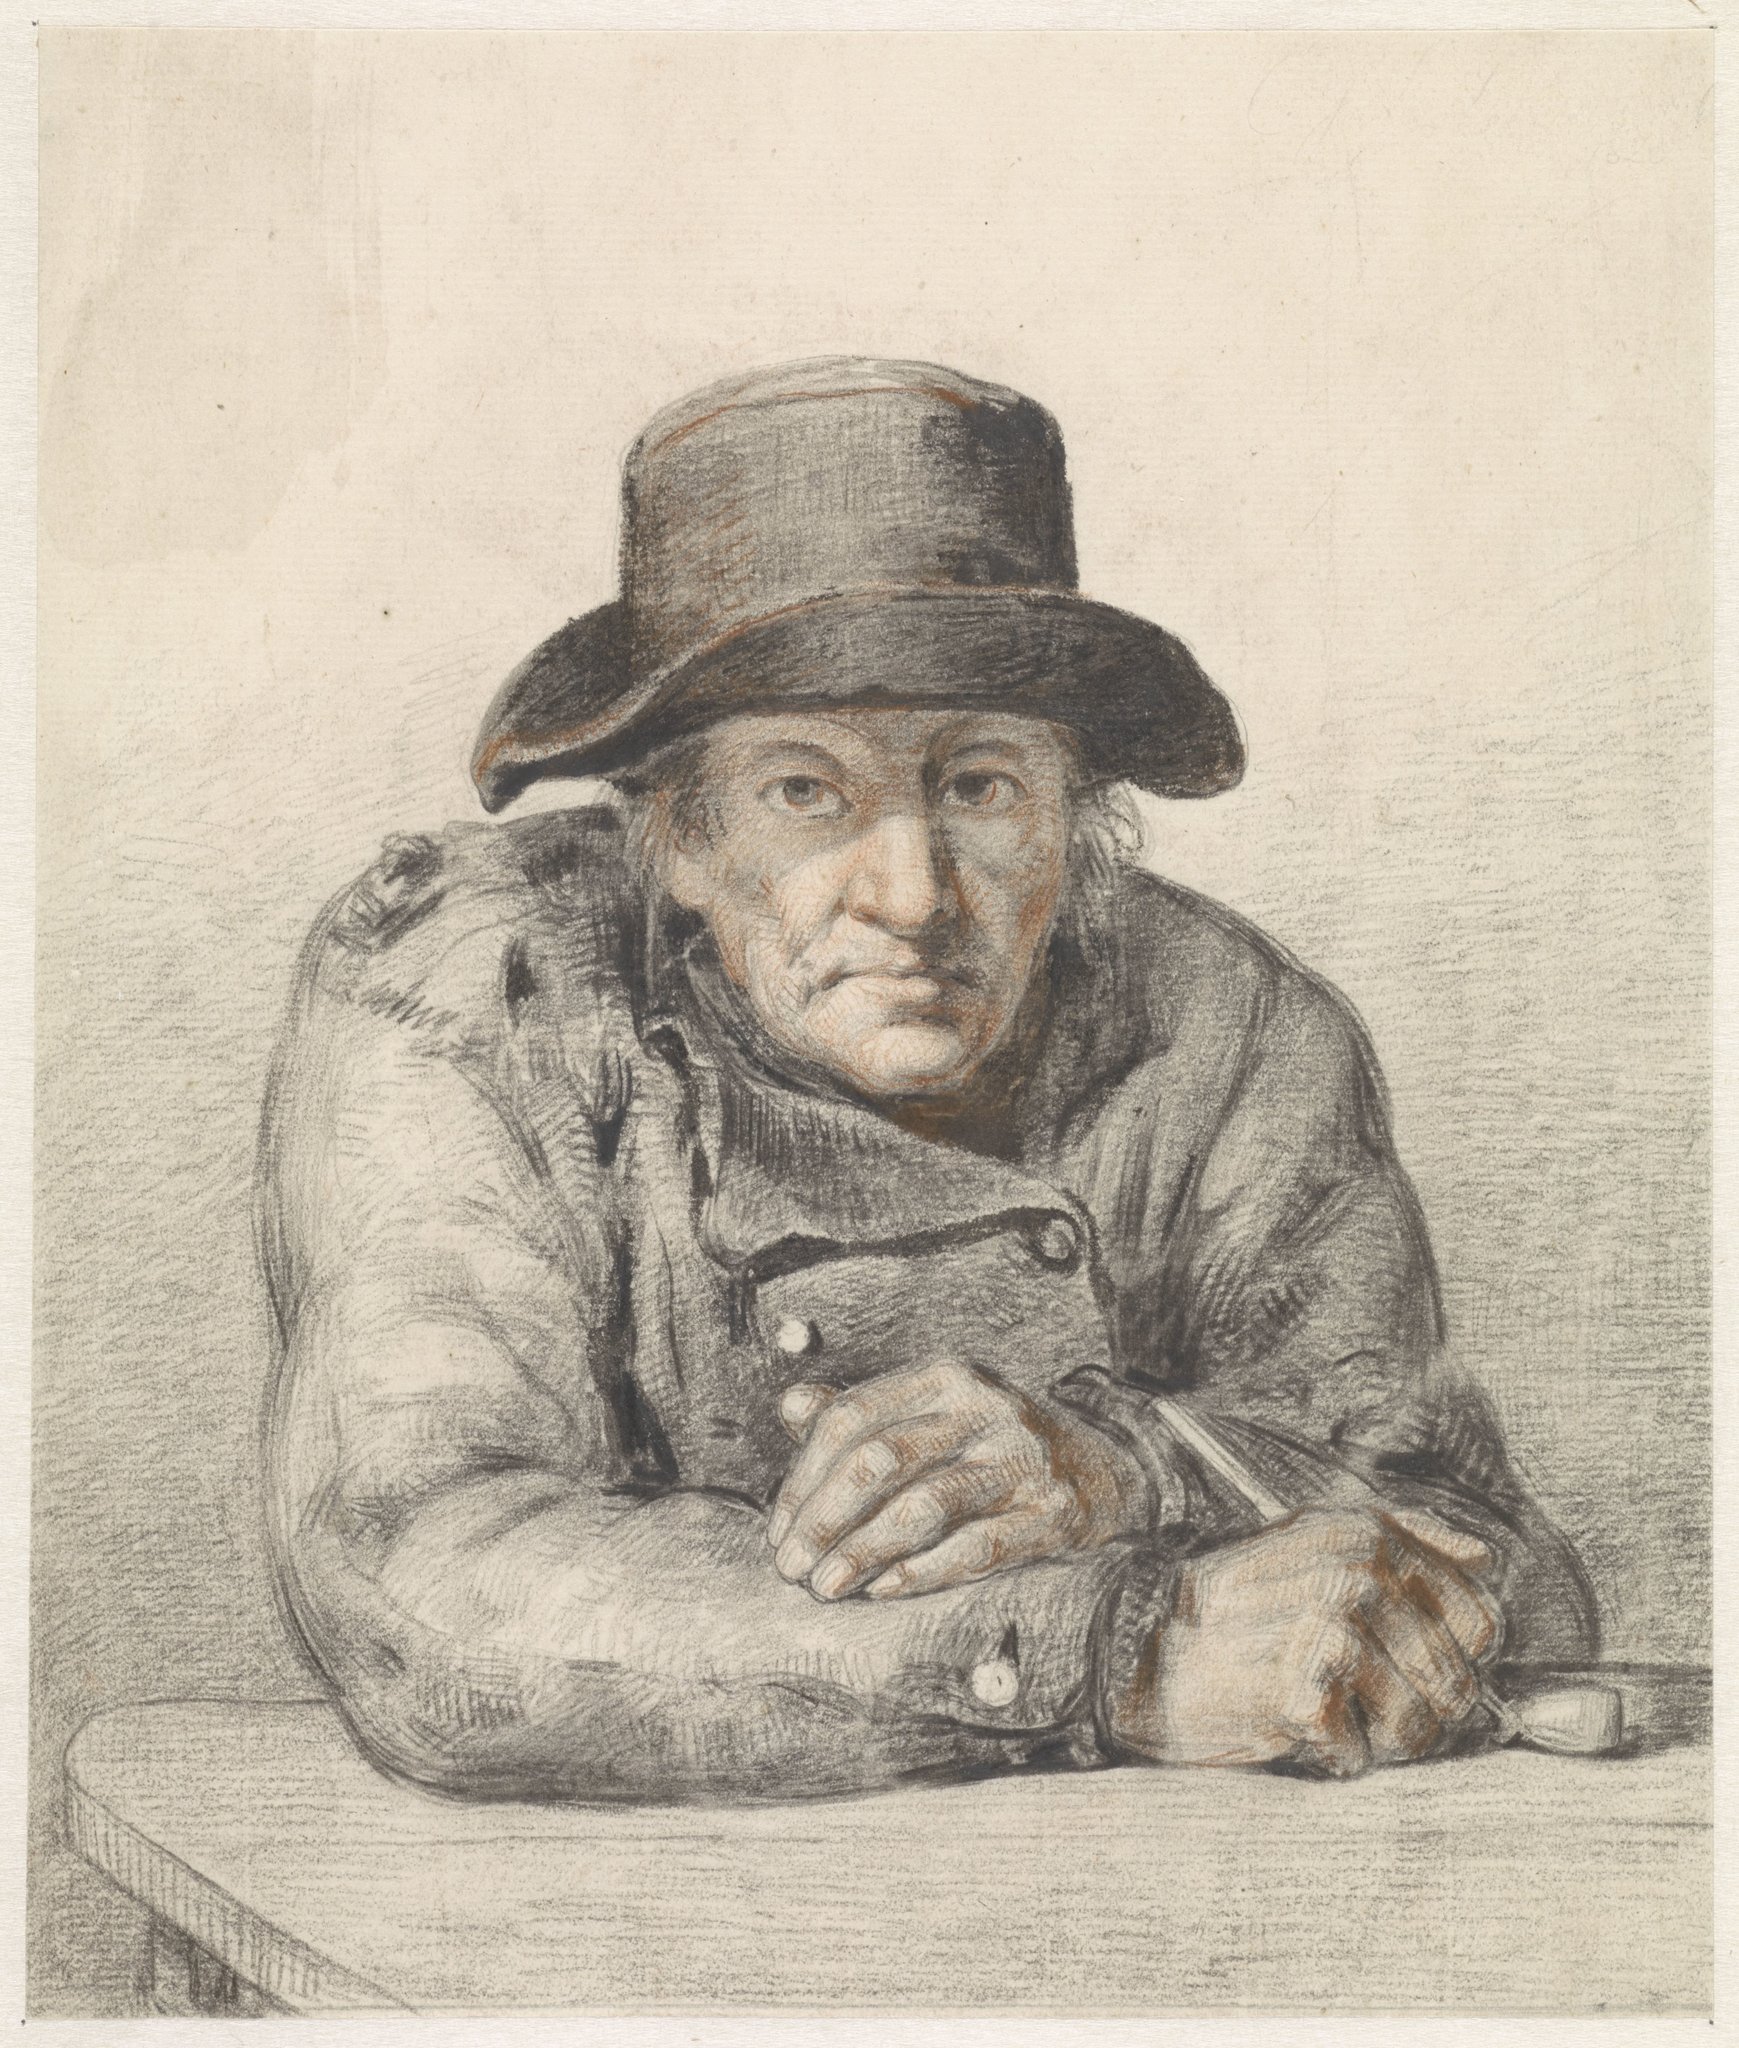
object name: drawing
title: Oude man met pijp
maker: jean augustin daiwaille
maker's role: draughtsman, print maker, printer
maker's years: 1786-1850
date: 1796-1850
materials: chalk, paper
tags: pipe ~ tobacco